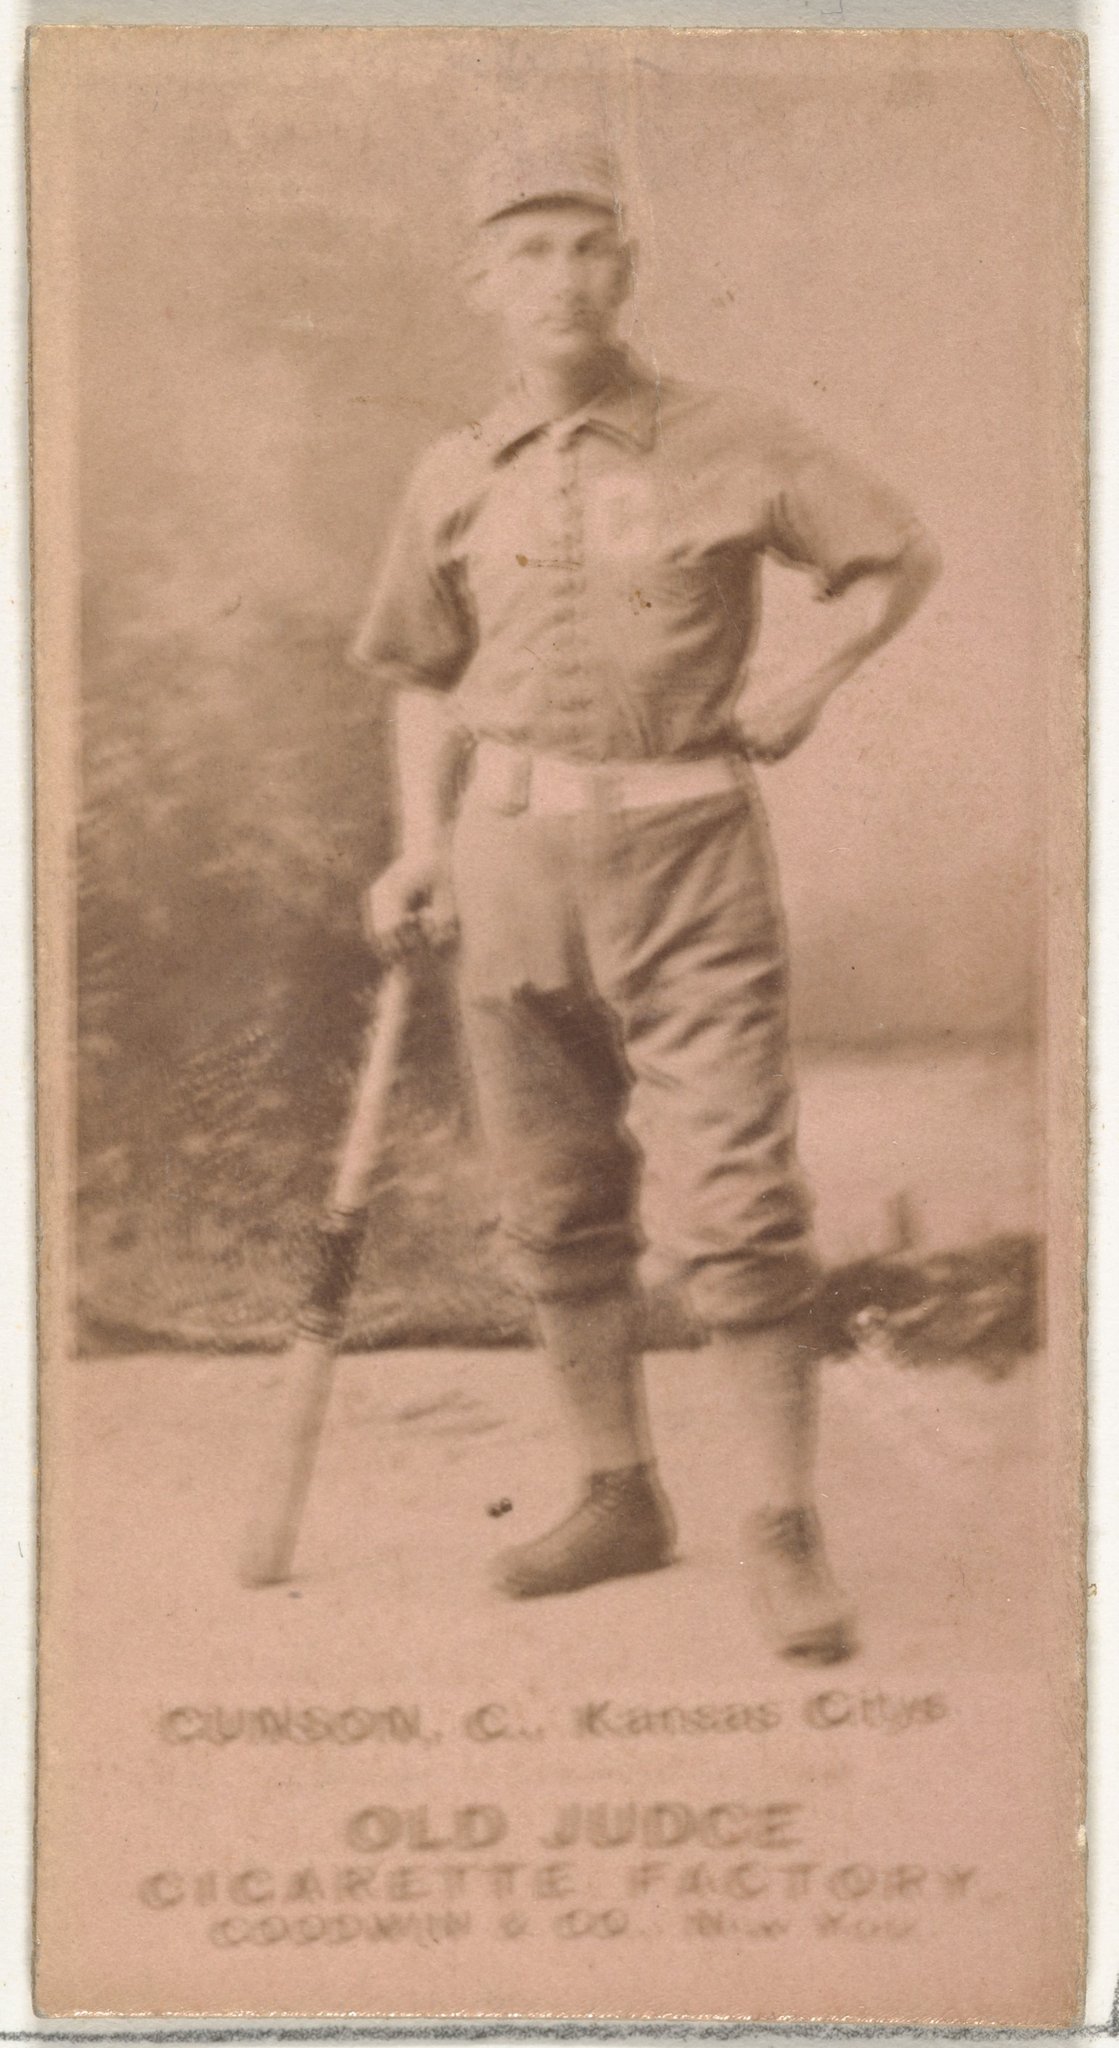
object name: baseball card, photograph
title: Joseph Brook "Joe" Gunson, Catcher, Kansas City Cowboys, from the Old Judge series (N172) for Old Judge Cigarettes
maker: goodwin & company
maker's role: publisher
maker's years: 1850-1950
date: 1888-1889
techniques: albumen silver print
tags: men,portraits,baseball,athletes